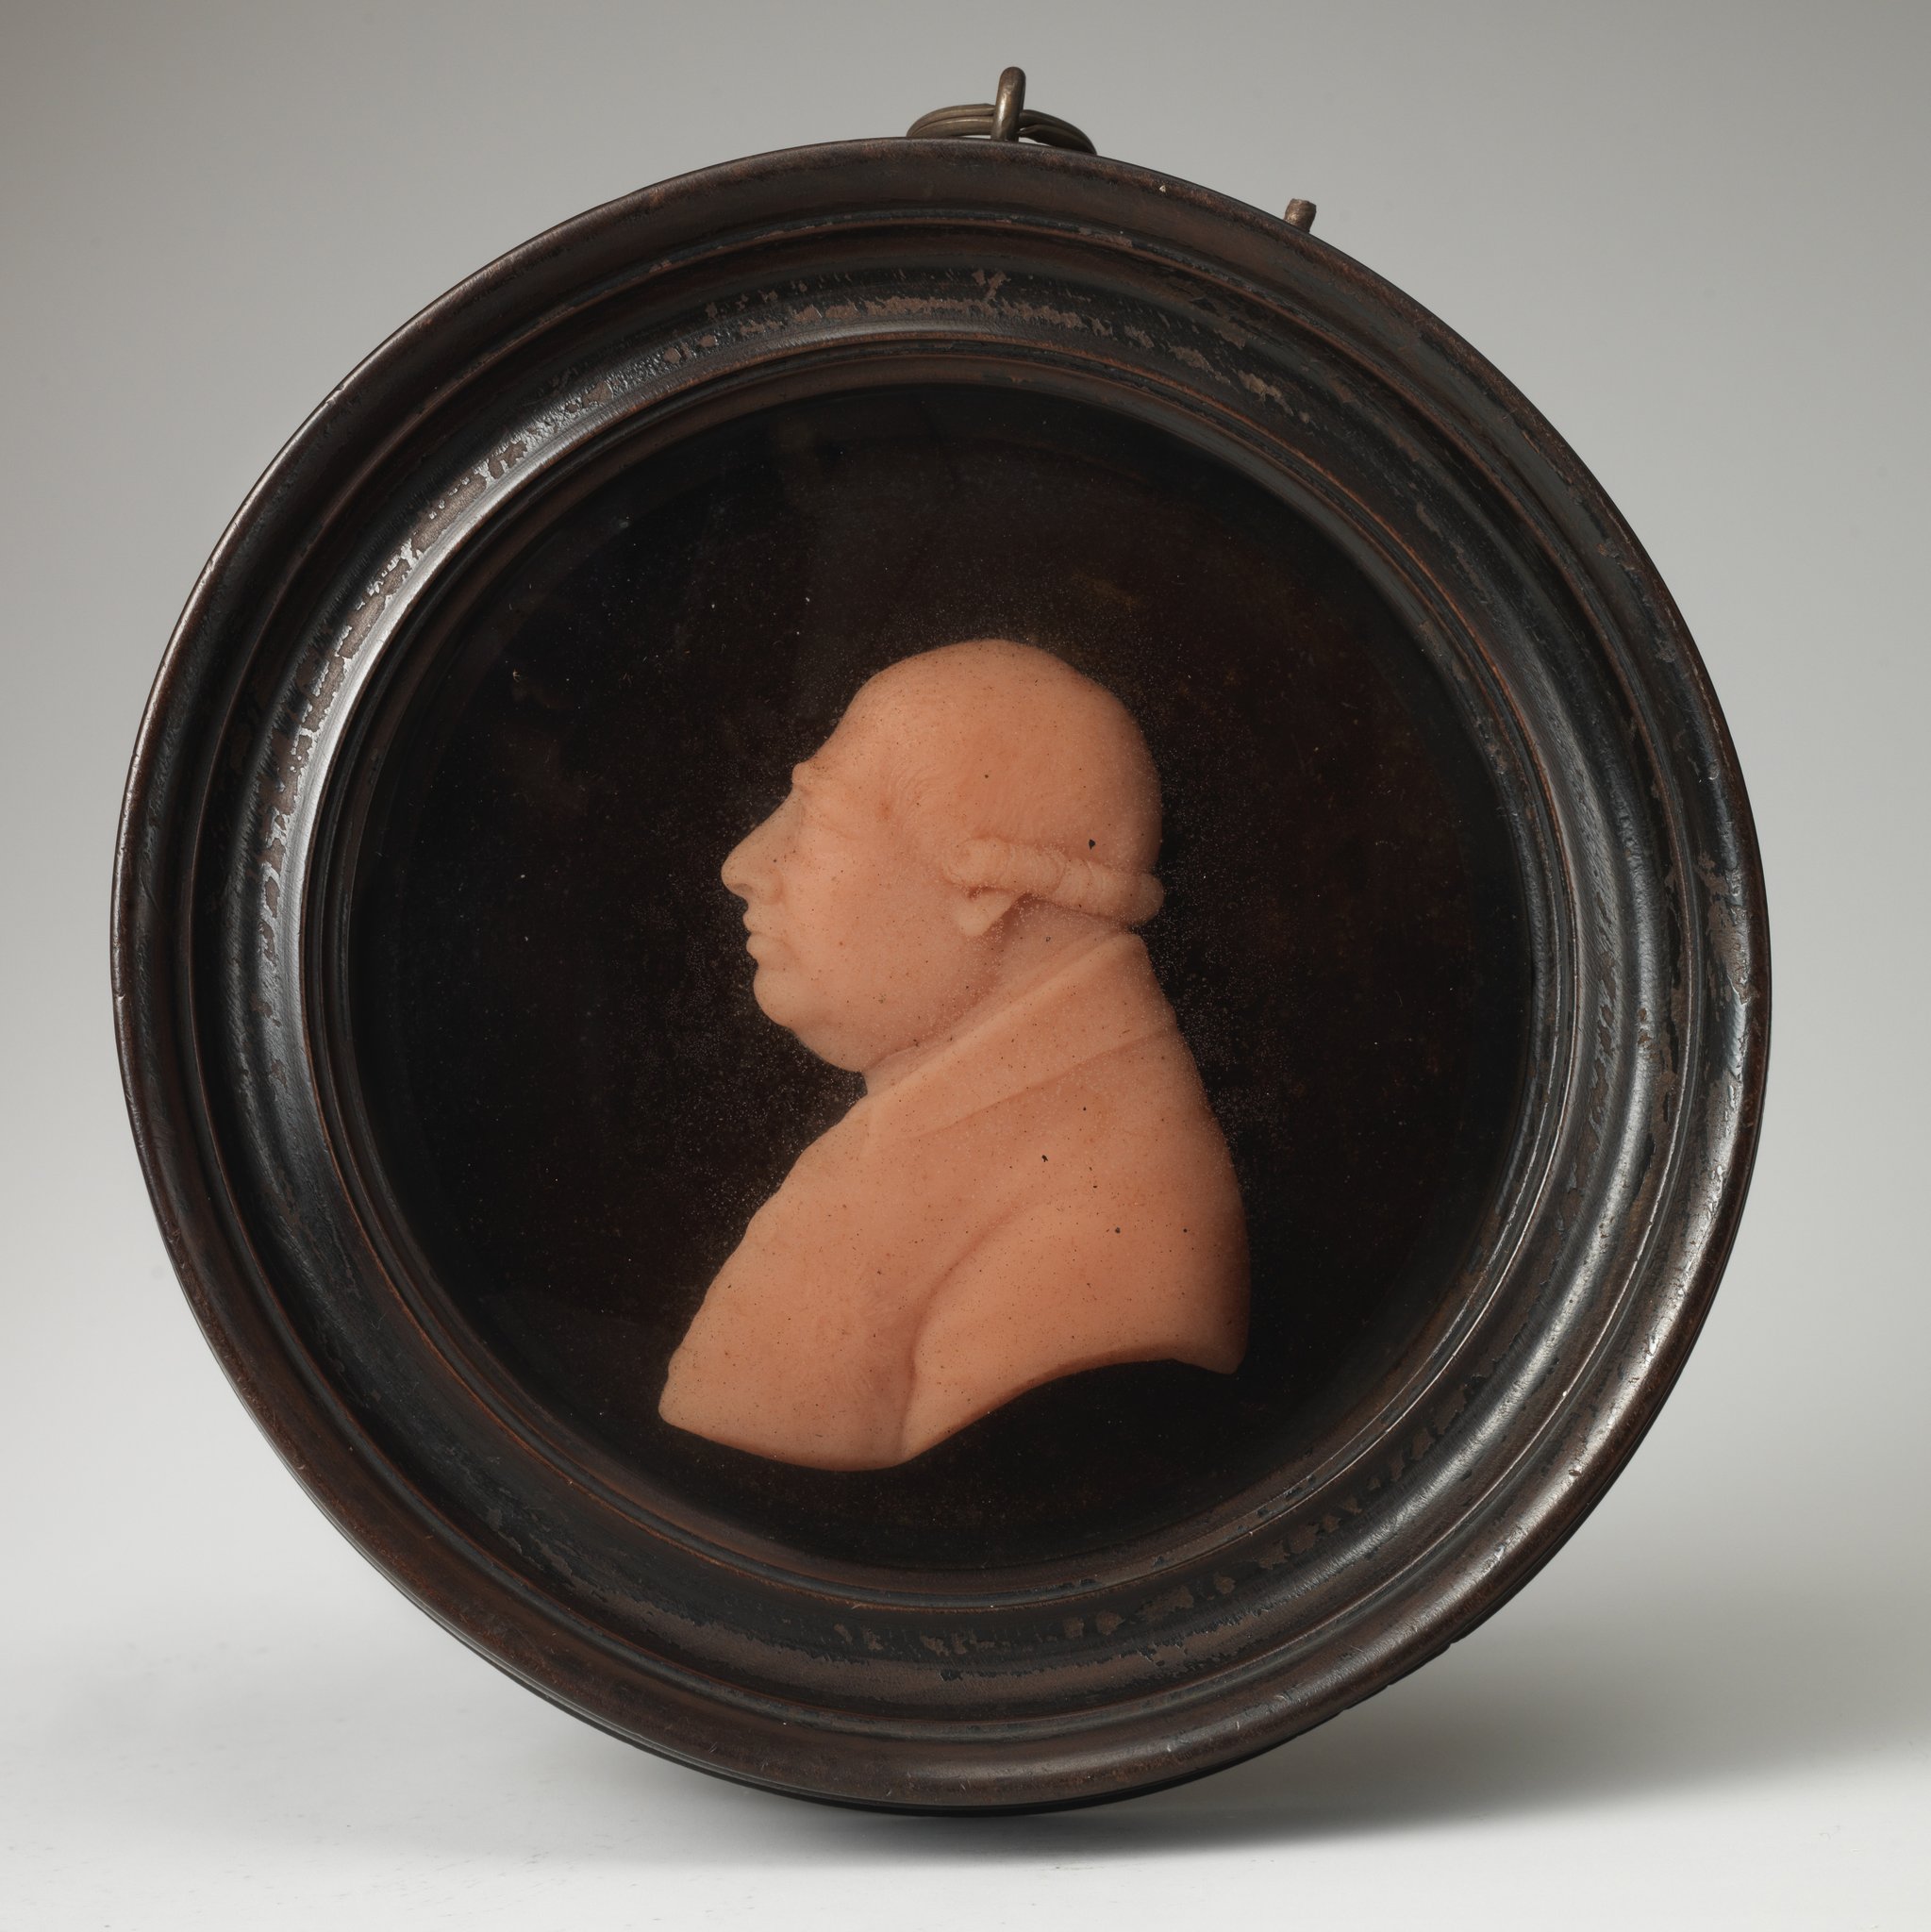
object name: medallion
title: George III (1738–1820), King of England (1760–1820)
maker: catherine andras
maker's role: artist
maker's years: 1775-1875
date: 1820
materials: glass, wax, wood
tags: kings,profiles,george iii